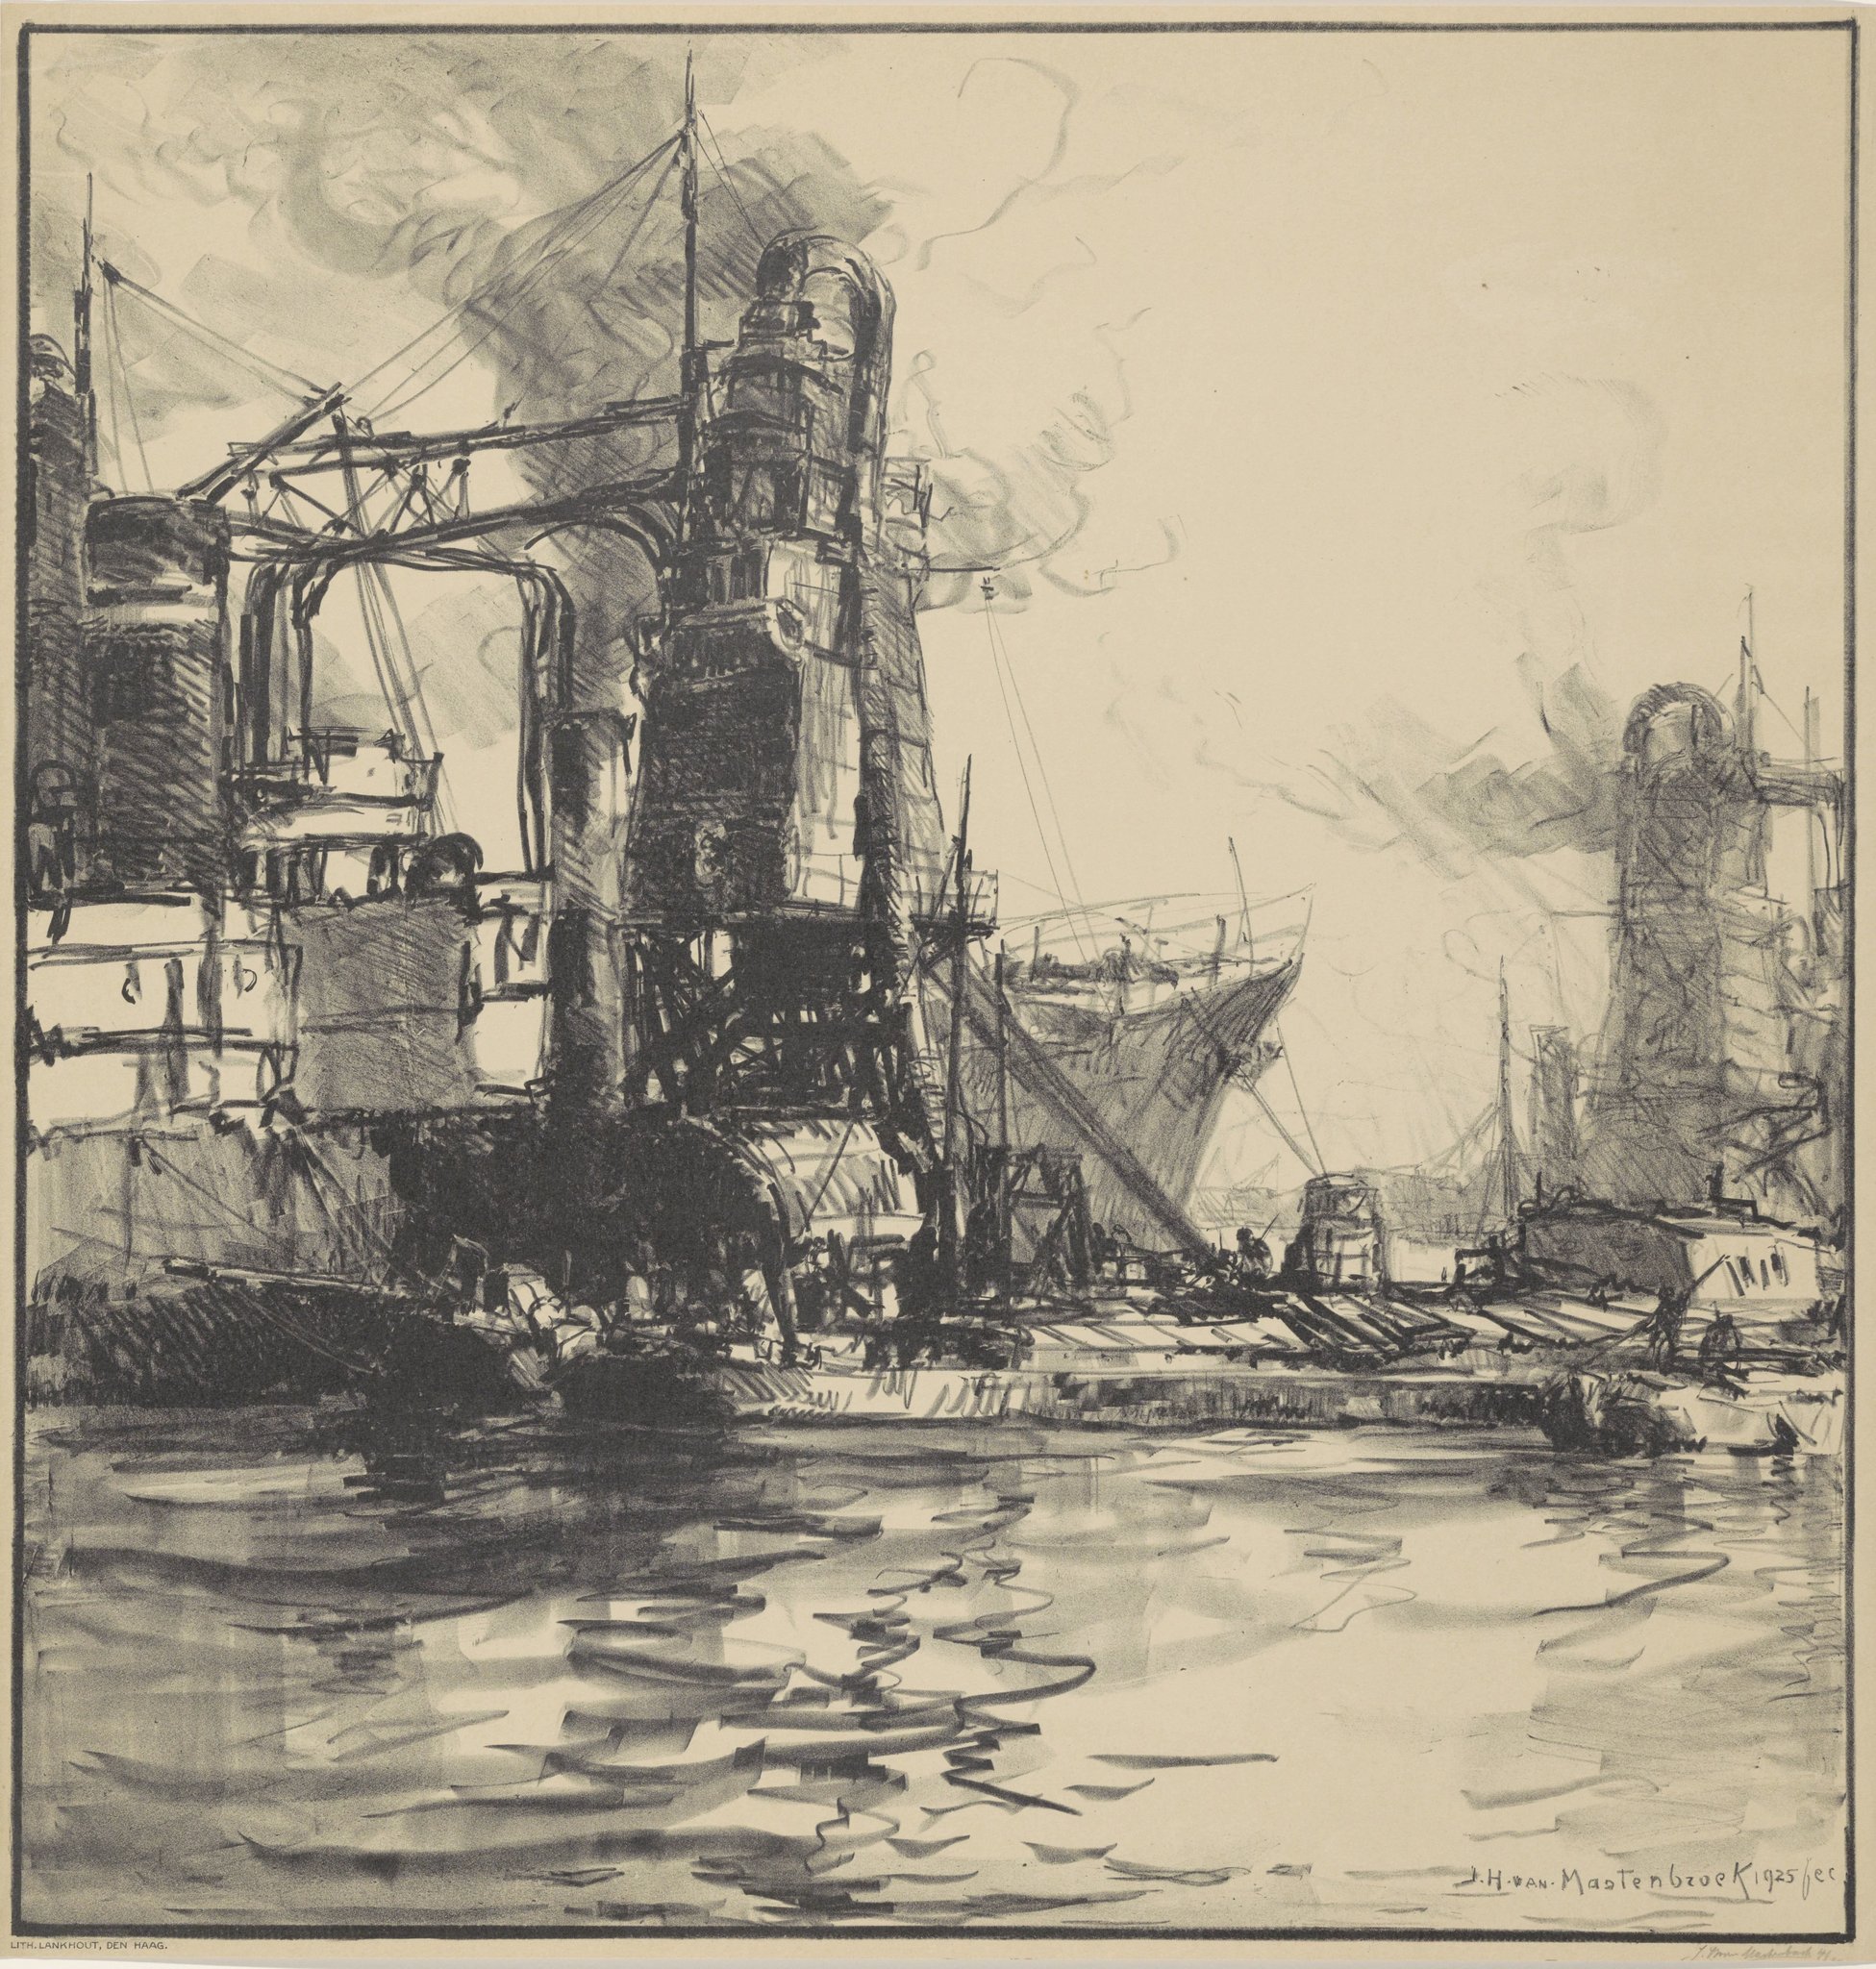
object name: print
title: Havengezicht te Rotterdam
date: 1885-1940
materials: paper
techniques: lithograph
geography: the hague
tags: harbour, ships (in general), rotterdam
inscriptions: collector's mark: Lugt 2228